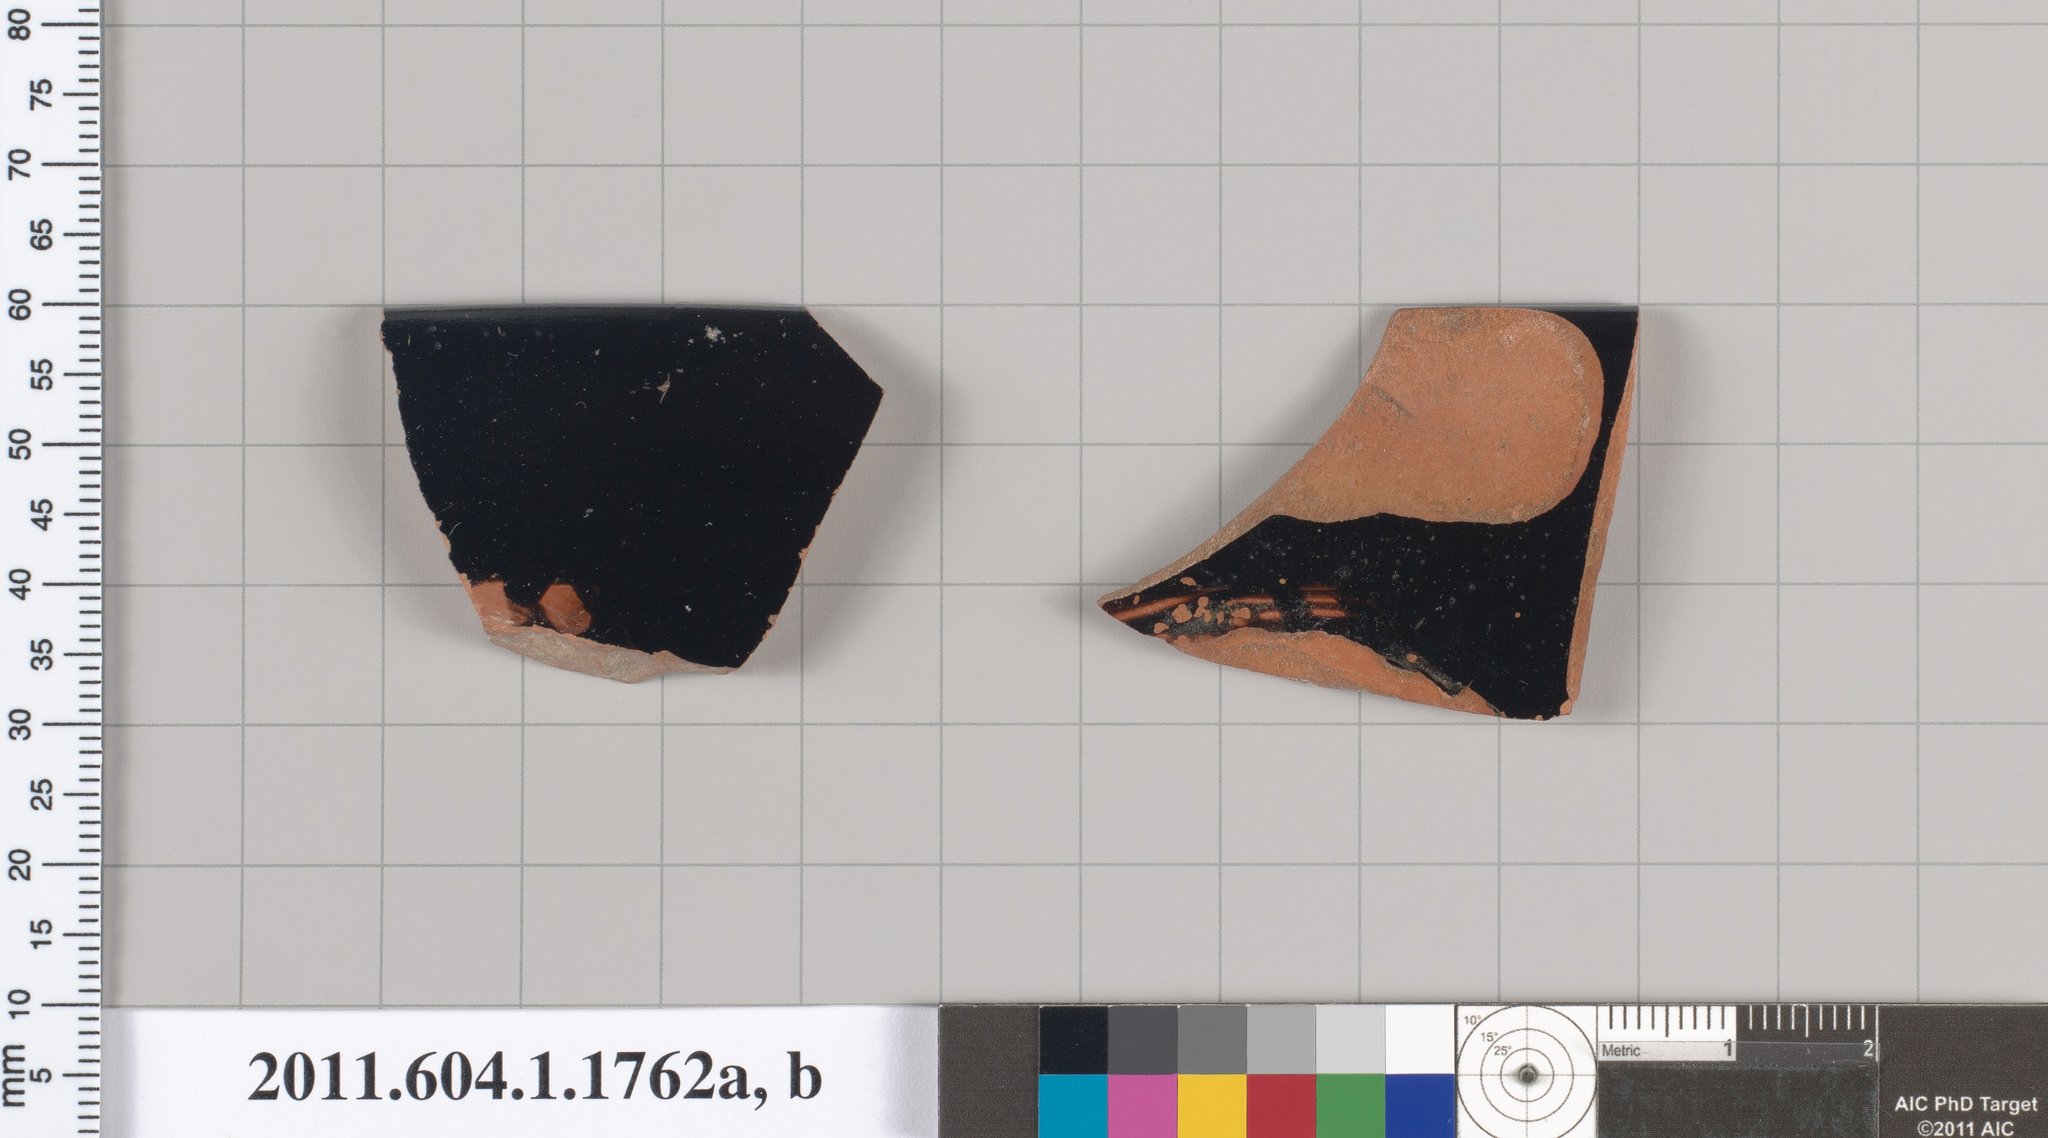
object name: kylix fragment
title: Terracotta rim fragments of kylikes(drinking cups)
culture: greek, attic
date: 500-401 BCE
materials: terracotta